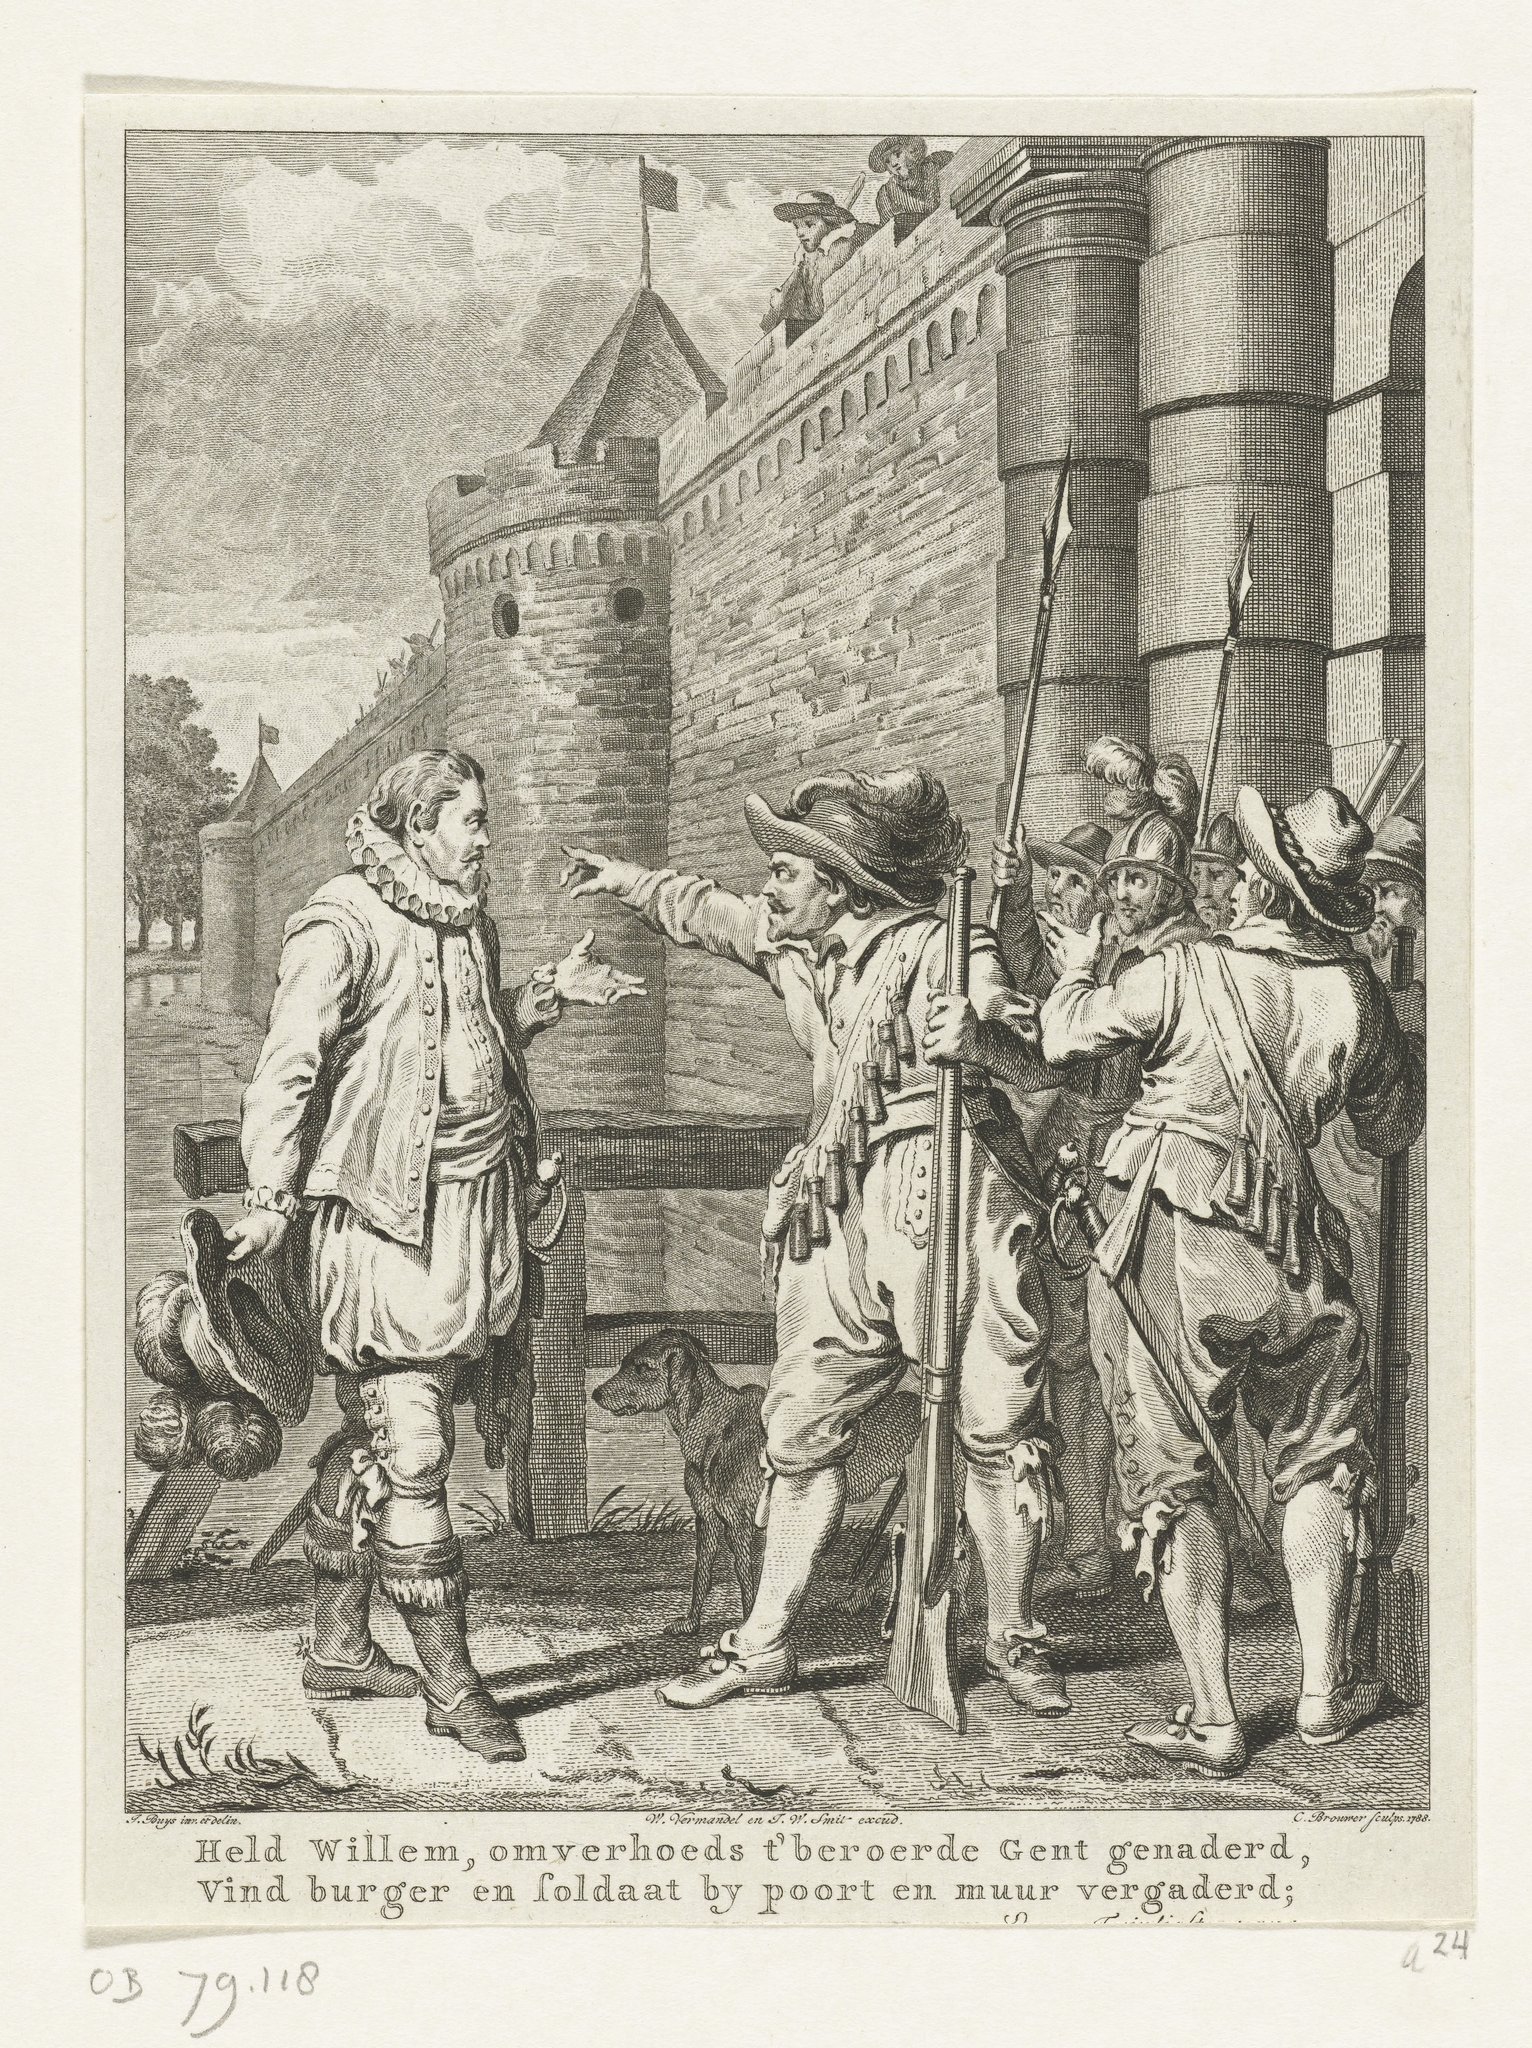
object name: print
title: Oranje bezoekt alleen het opstandige Gent, ca. 1579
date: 1788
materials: paper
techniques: etching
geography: northern netherlands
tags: william i (prince of orange), ghent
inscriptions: date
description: Illustratie voor: J. Nomsz, Willem de eerste, of de grondlegging der Nederlandsche vryheid. : In vier en twintig zangen, Erven van David Klippink, Amsterdam 1779. Staat met de letter.